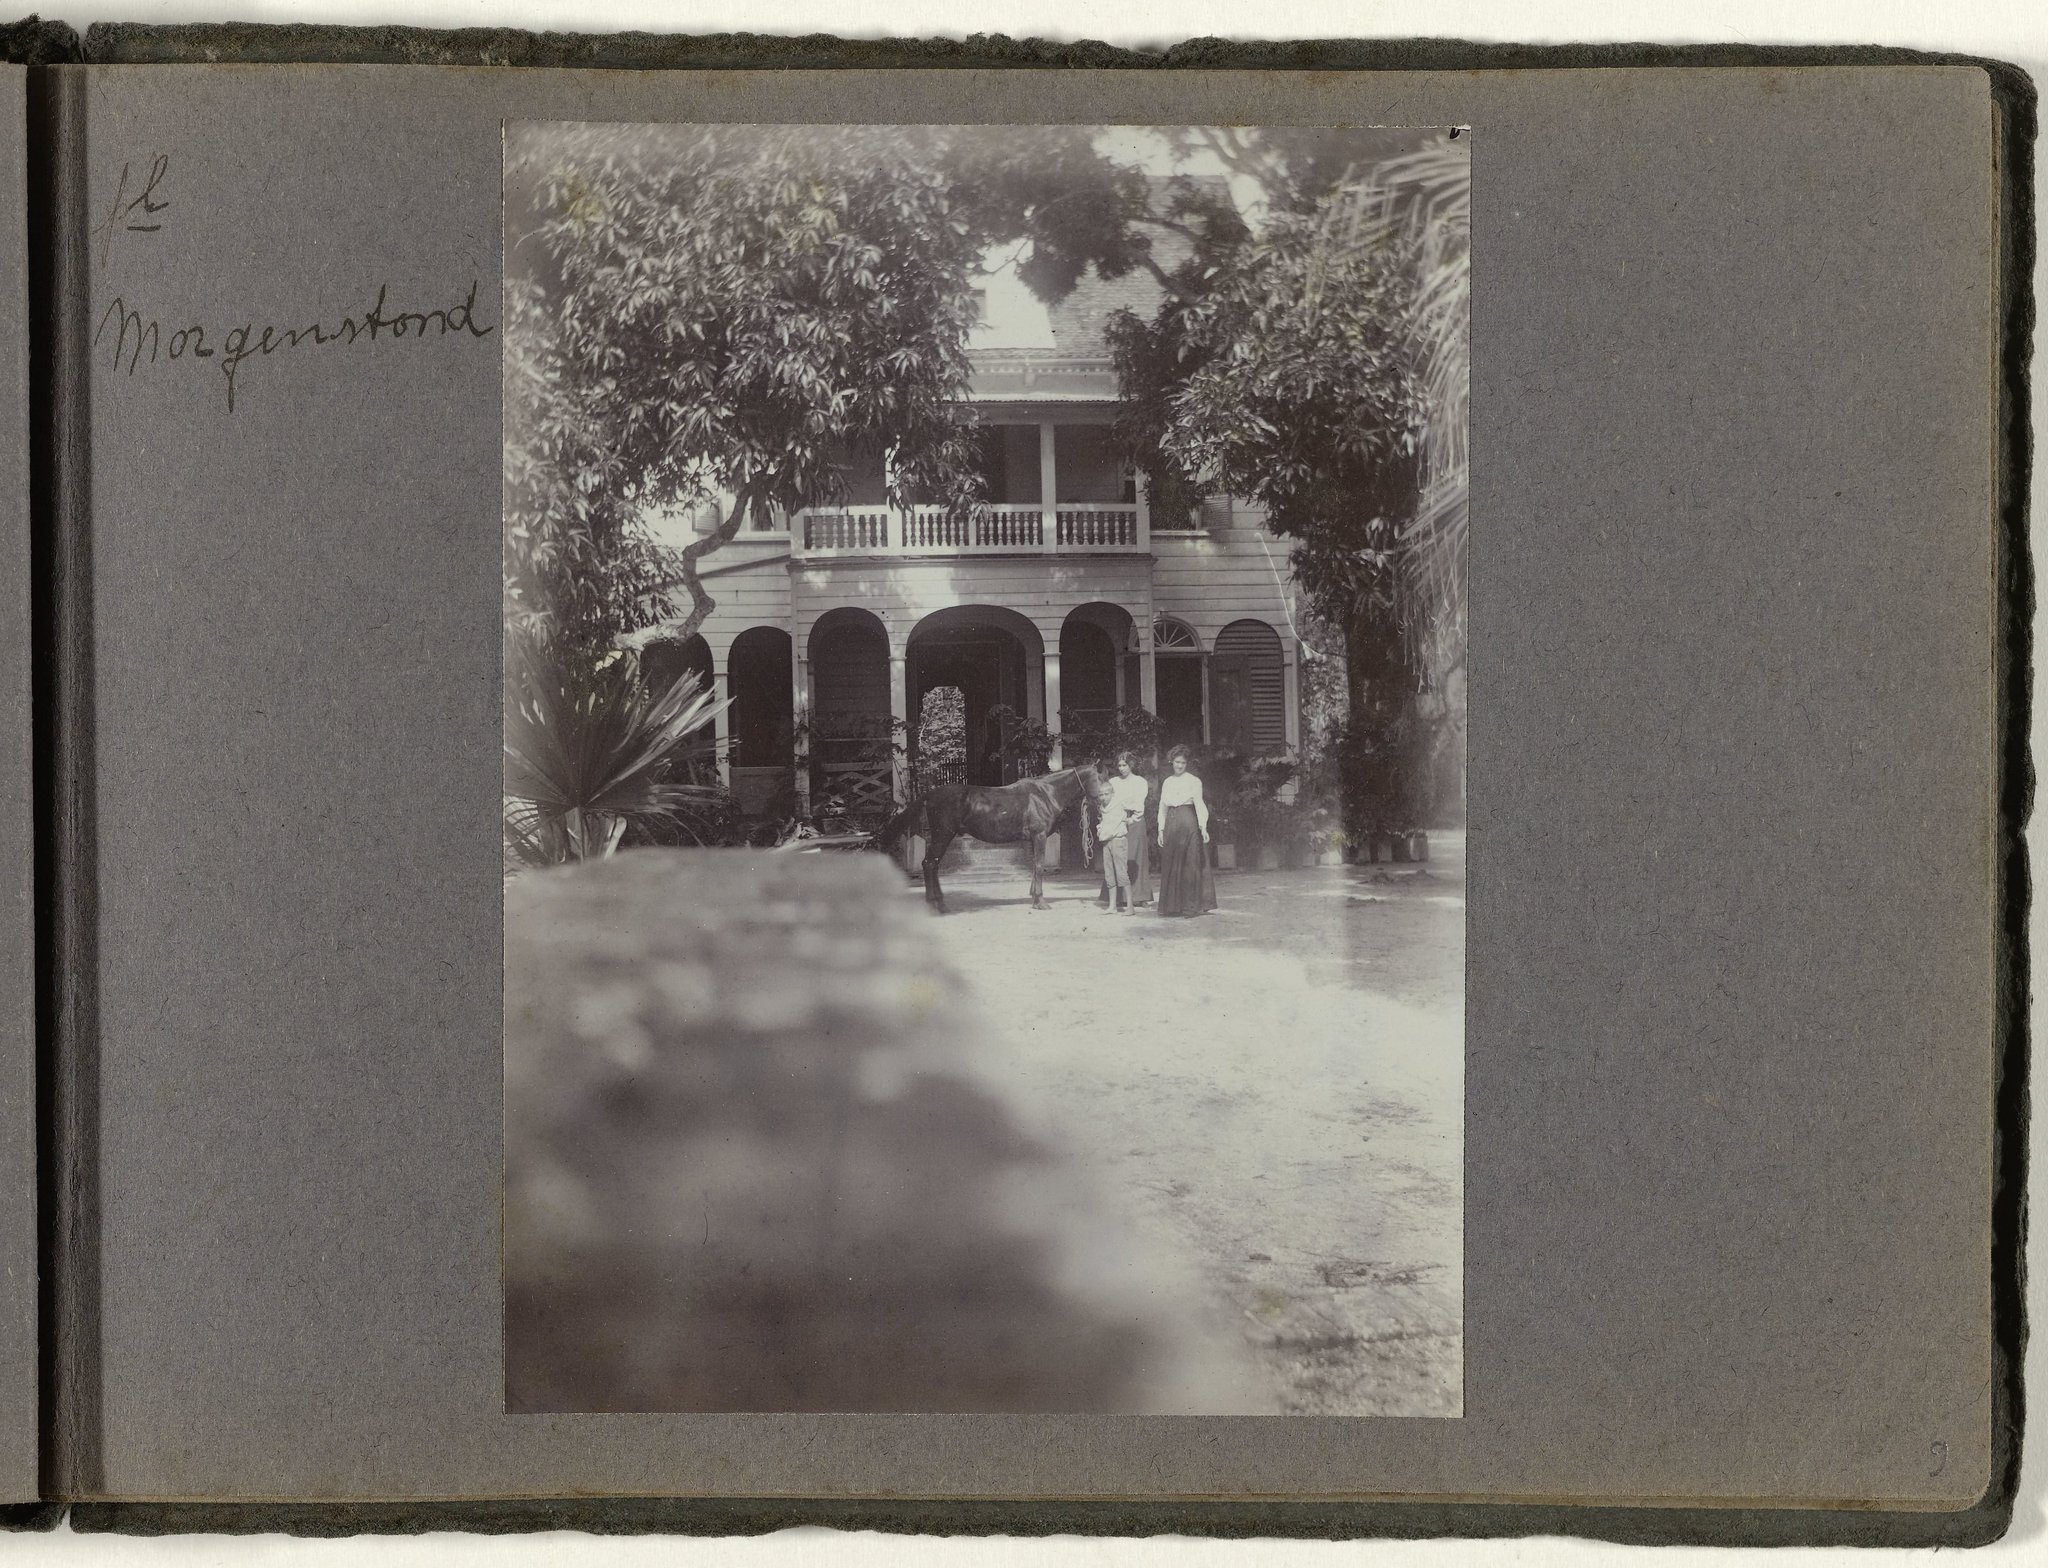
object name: photograph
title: Plantagehuis op Morgenstond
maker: Anonymous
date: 1908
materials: photographic support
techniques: gelatin silver print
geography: suriname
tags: plantation, suriname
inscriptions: inscription: ‘pl Morgenstond’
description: Anna Barbara Gonggrijp, Stephanie Gonggrijp en Hans Gonggrijp staande voor een huis op de plantage Morgenstond. Onderdeel van het fotoalbum over de familie Gonggrijp op de plantages Clevia en Morgenstond in Suriname rond 1910.